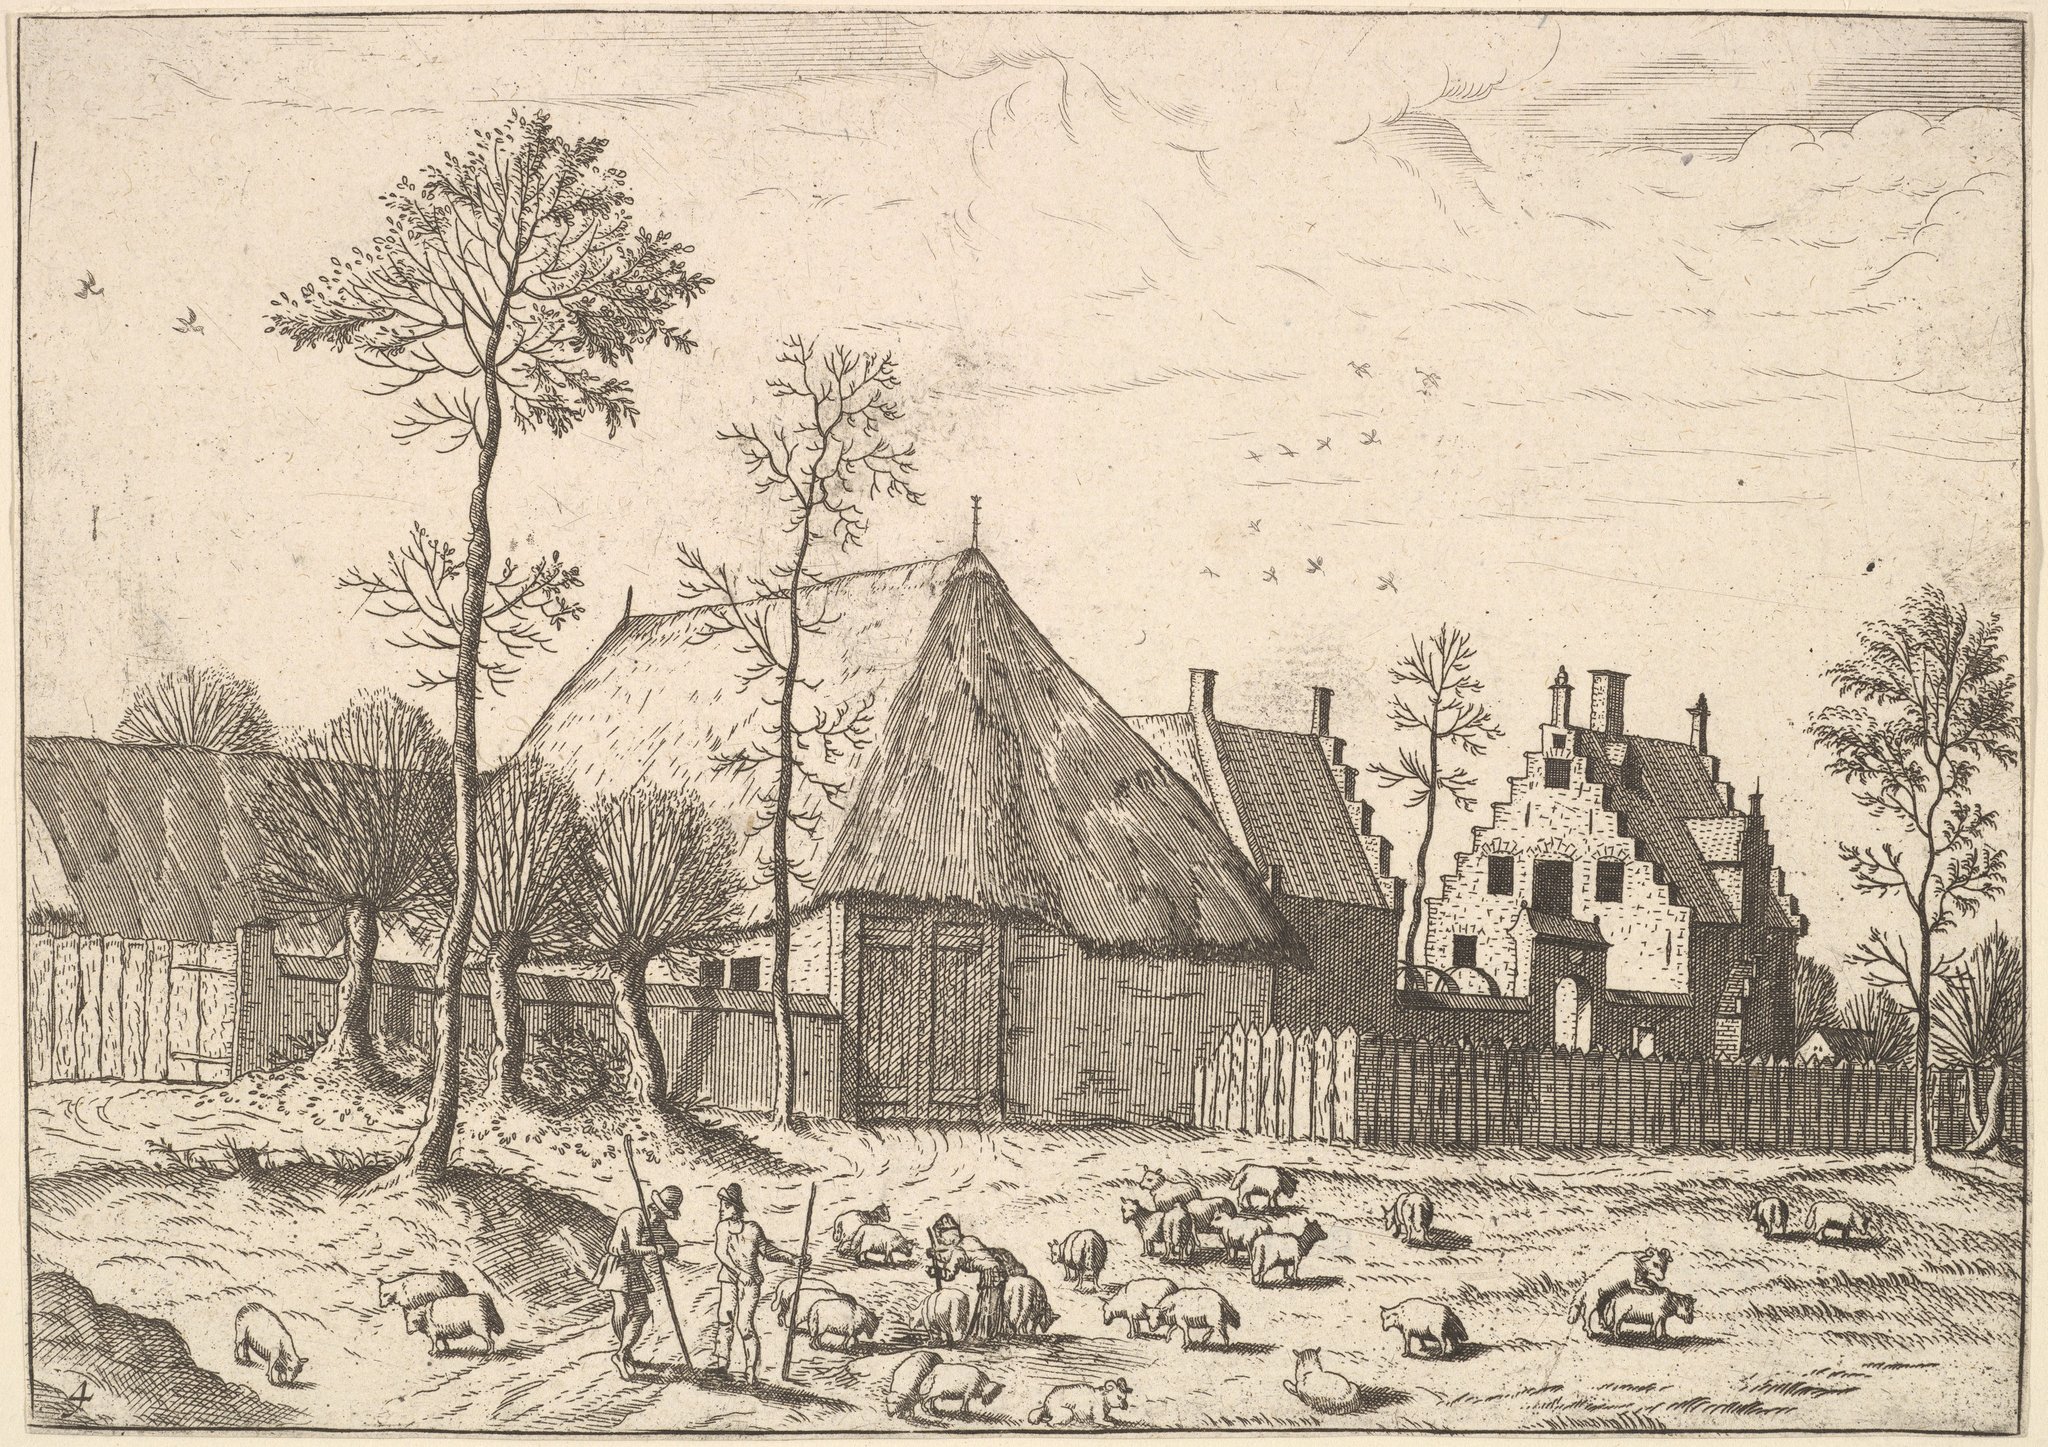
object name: print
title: Shed with Cottage, from The Small Landscapes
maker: johannes van doetecum i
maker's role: artist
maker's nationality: netherlandish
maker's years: 1528-1605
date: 1559-1561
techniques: etching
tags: animals,houses,men,landscapes